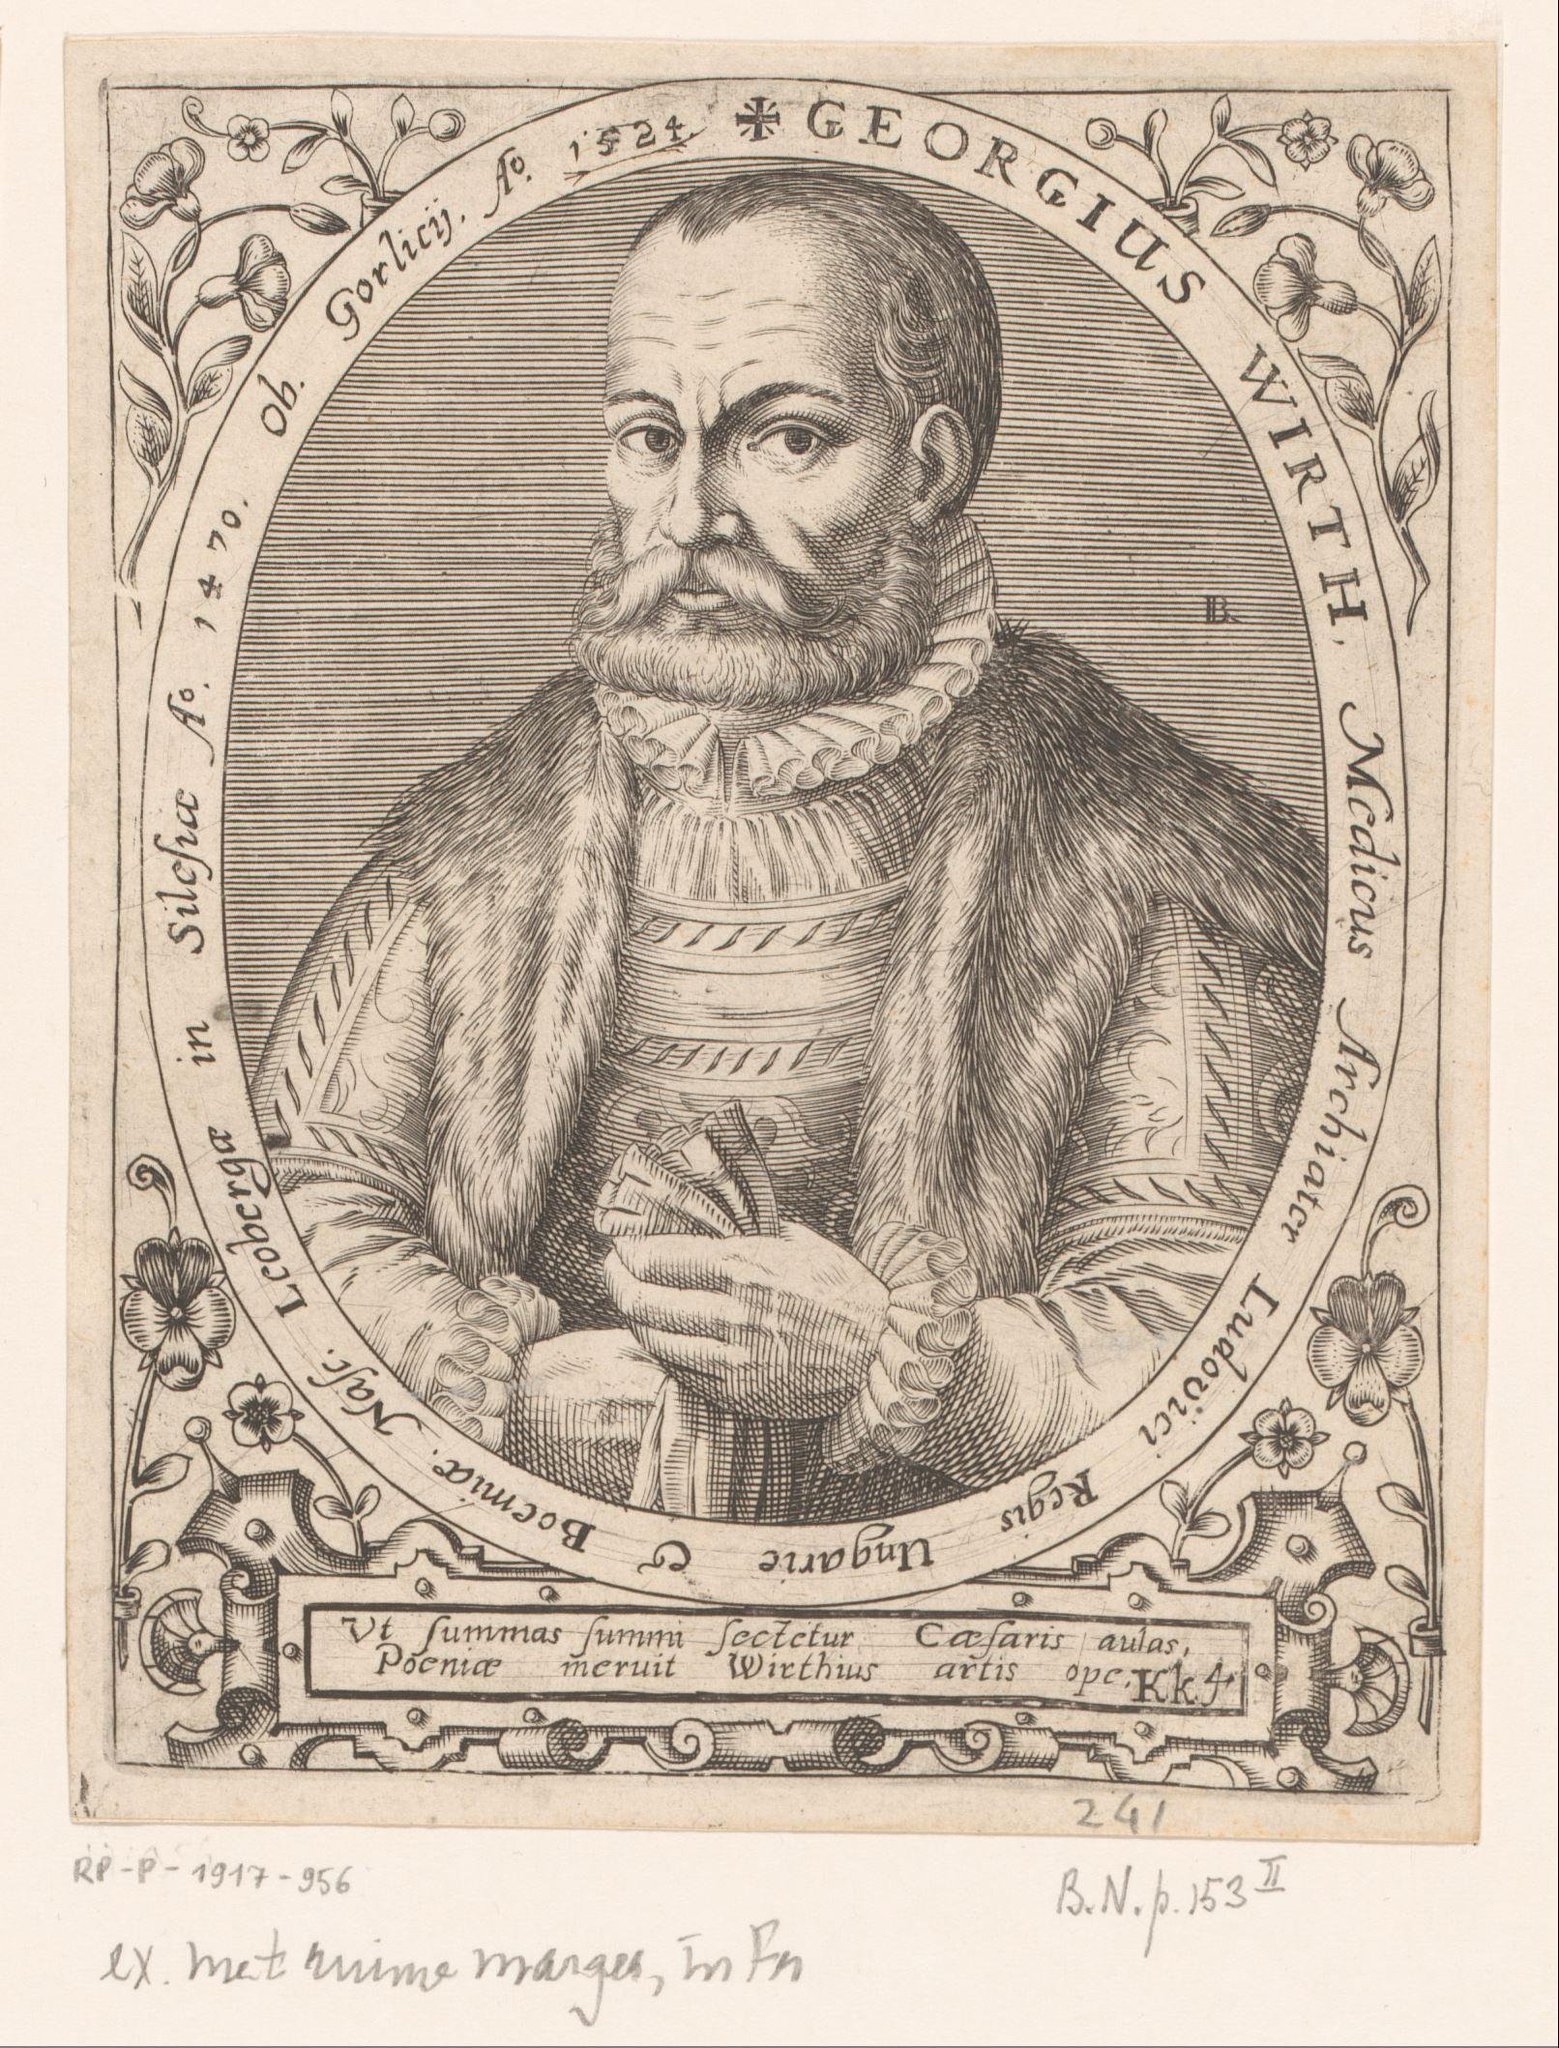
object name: print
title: Georgius Wirth Medicus Archiater Ludovici Regis Ungarie (...)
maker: robert boissard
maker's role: print maker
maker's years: 1570-1611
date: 1597-1599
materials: paper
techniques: engraving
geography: france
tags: gloves, mittens, etc., historical persons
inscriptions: collector's mark: Lugt 2228